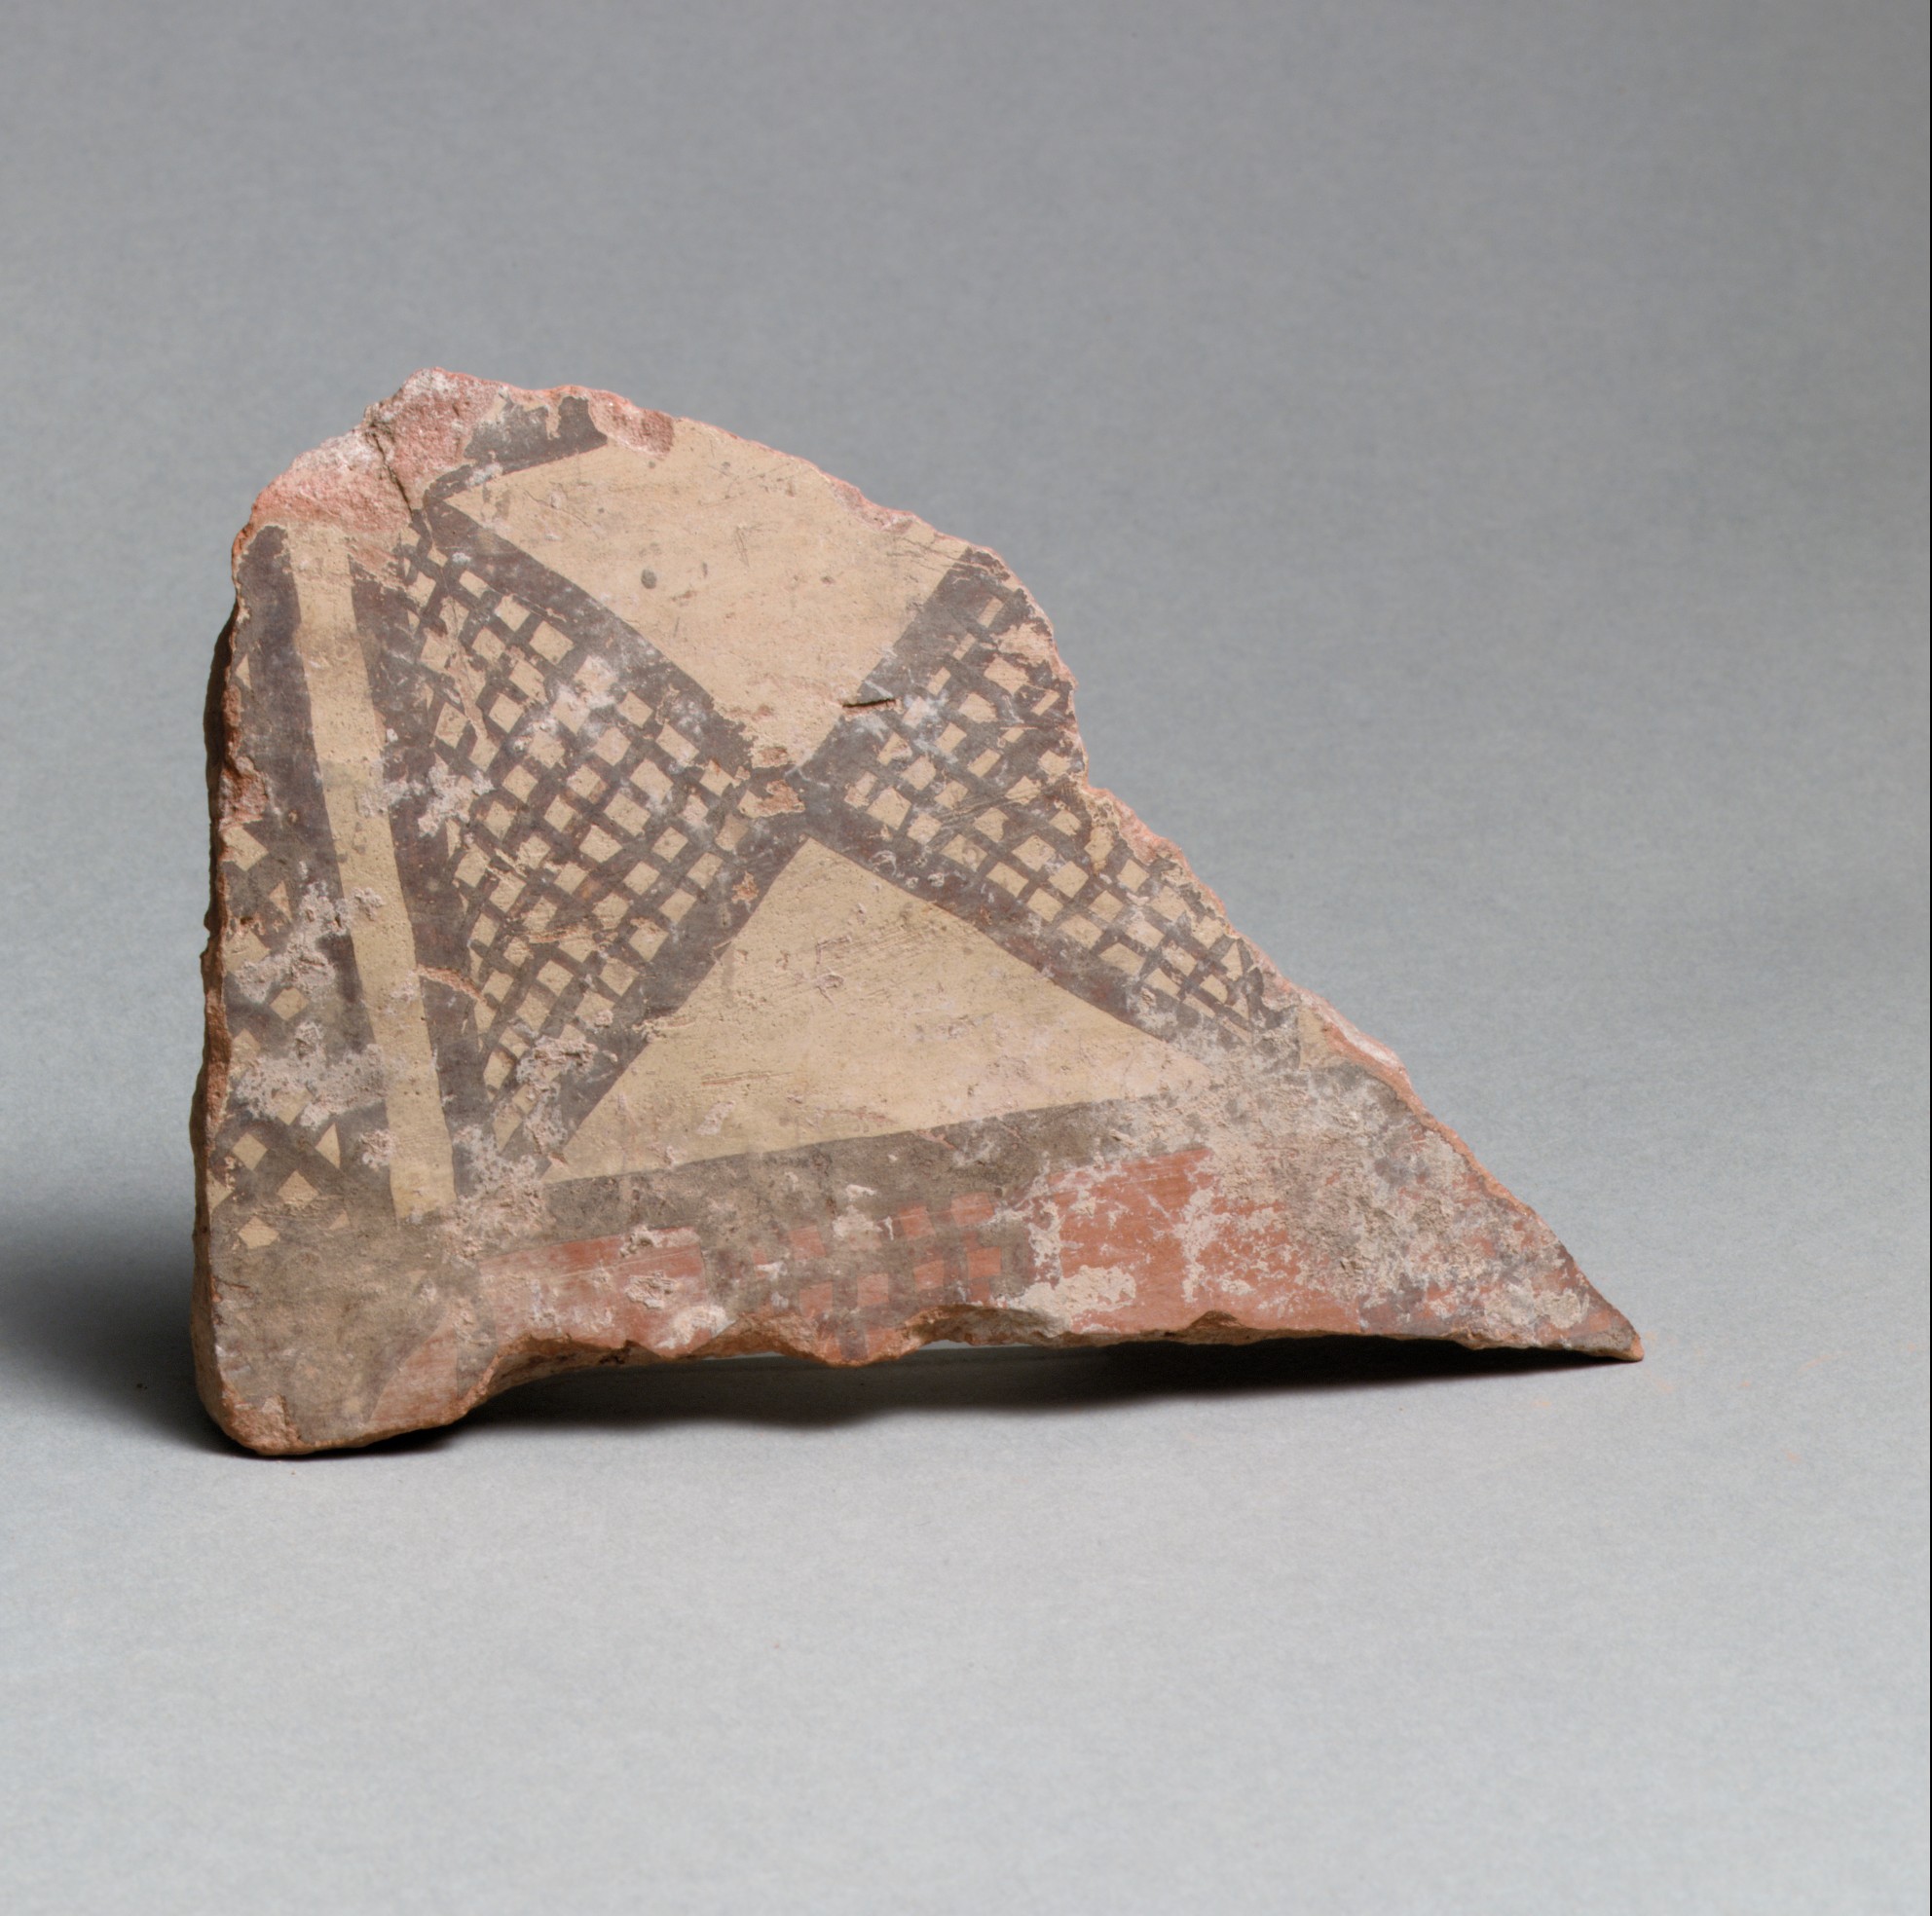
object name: vase fragment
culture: greek or lydian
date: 1050-700 BCE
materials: terracotta